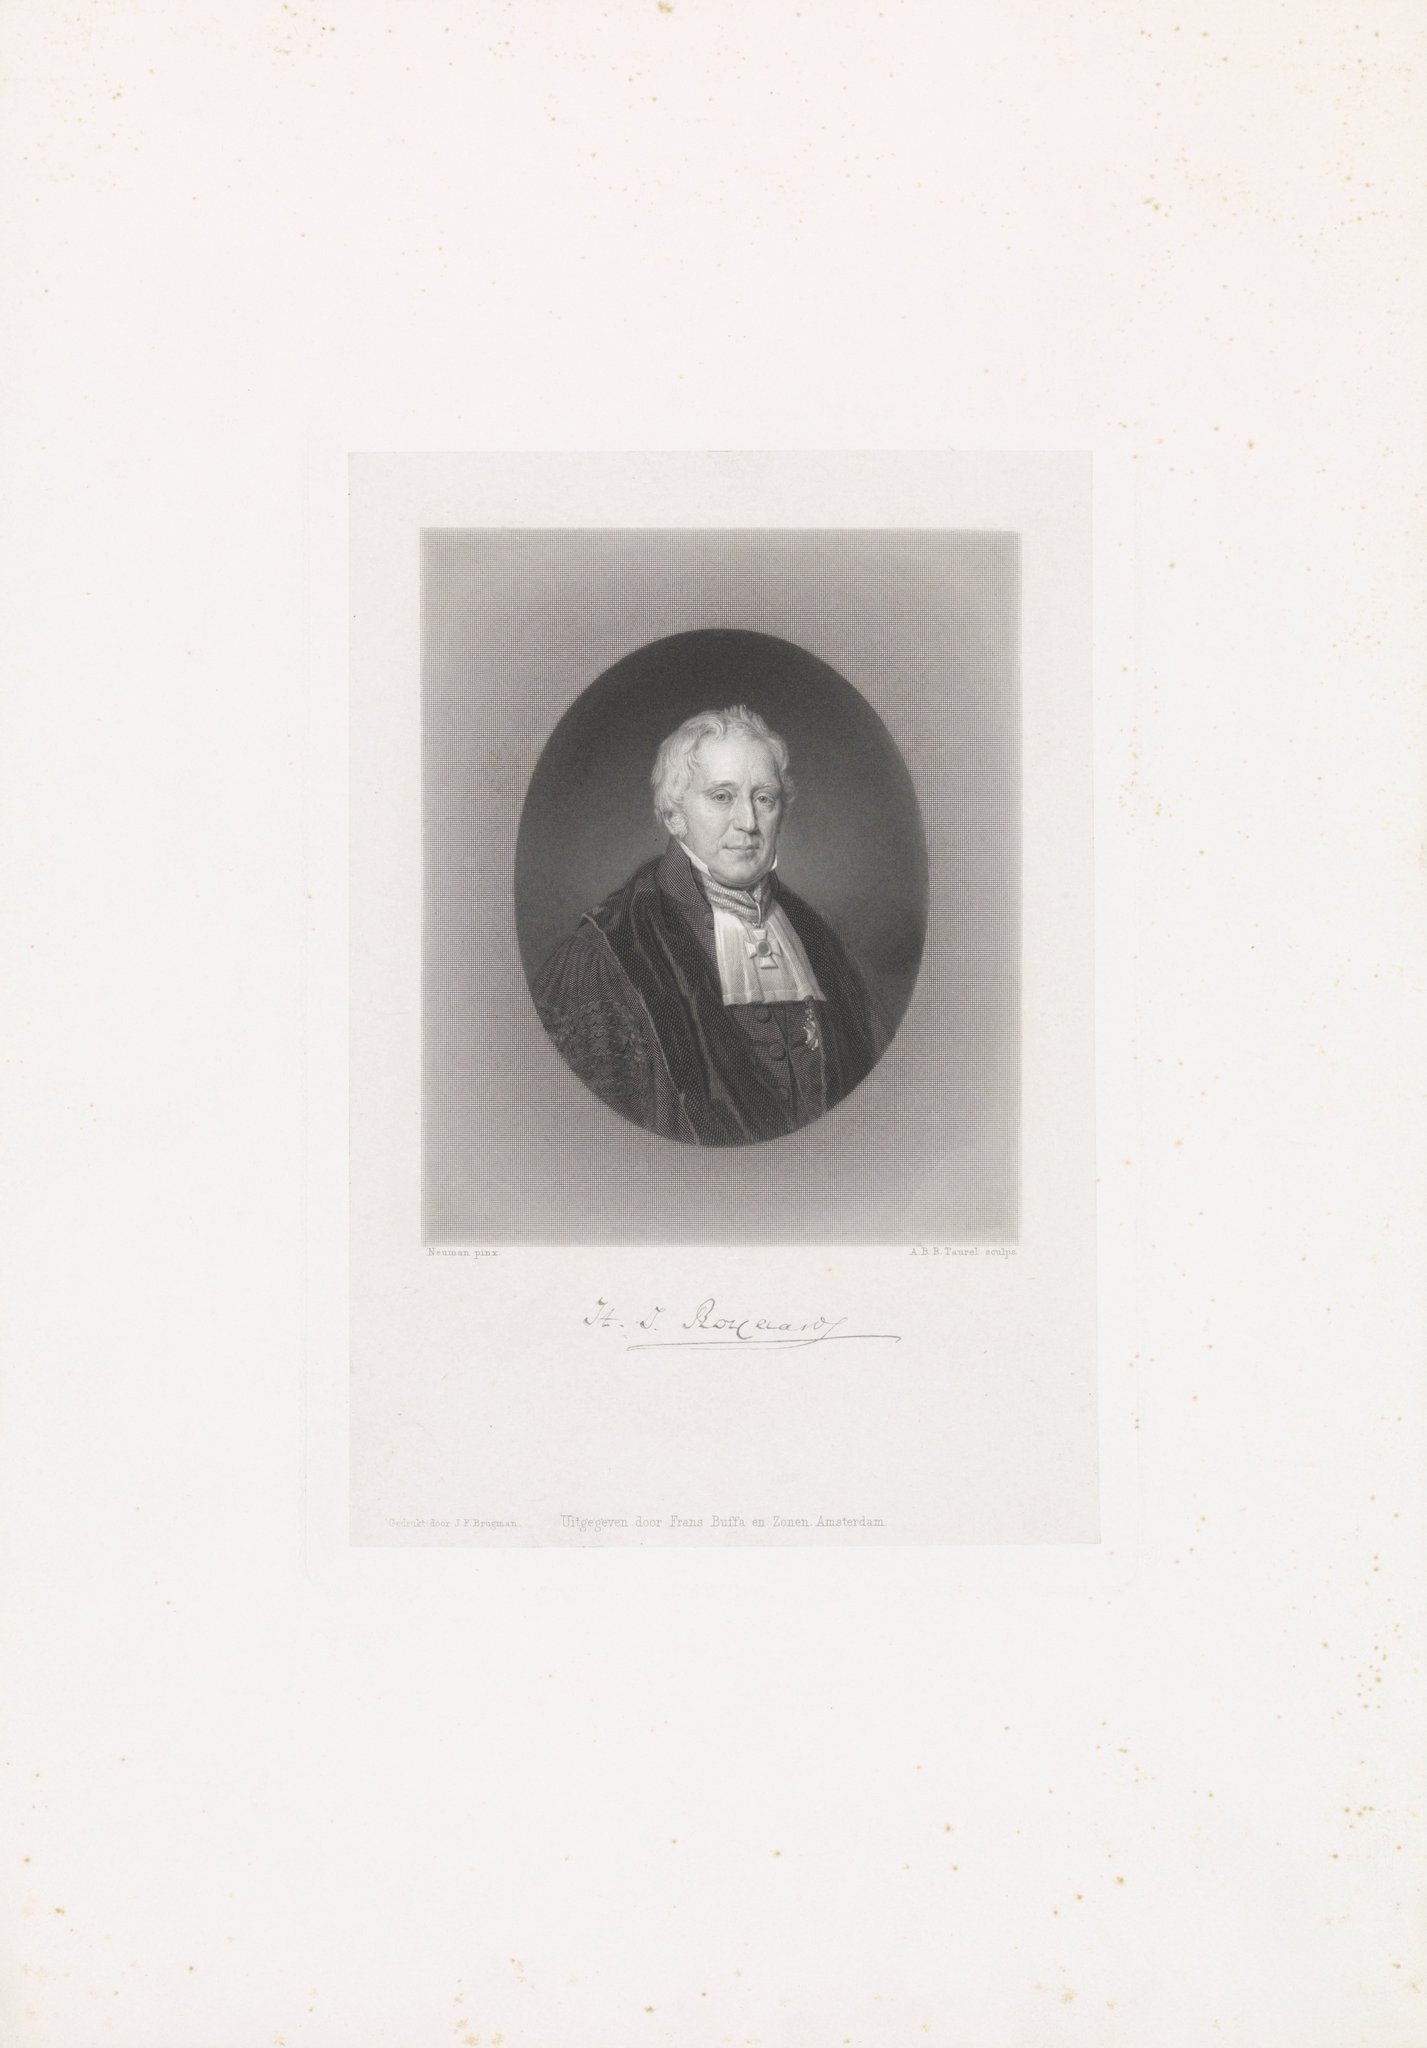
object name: print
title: Portret van de theoloog Herman Johan Royaards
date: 1834-1859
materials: paper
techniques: engraving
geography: amsterdam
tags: utrecht, herman johan royaards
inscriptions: collector's mark: Lugt 2228